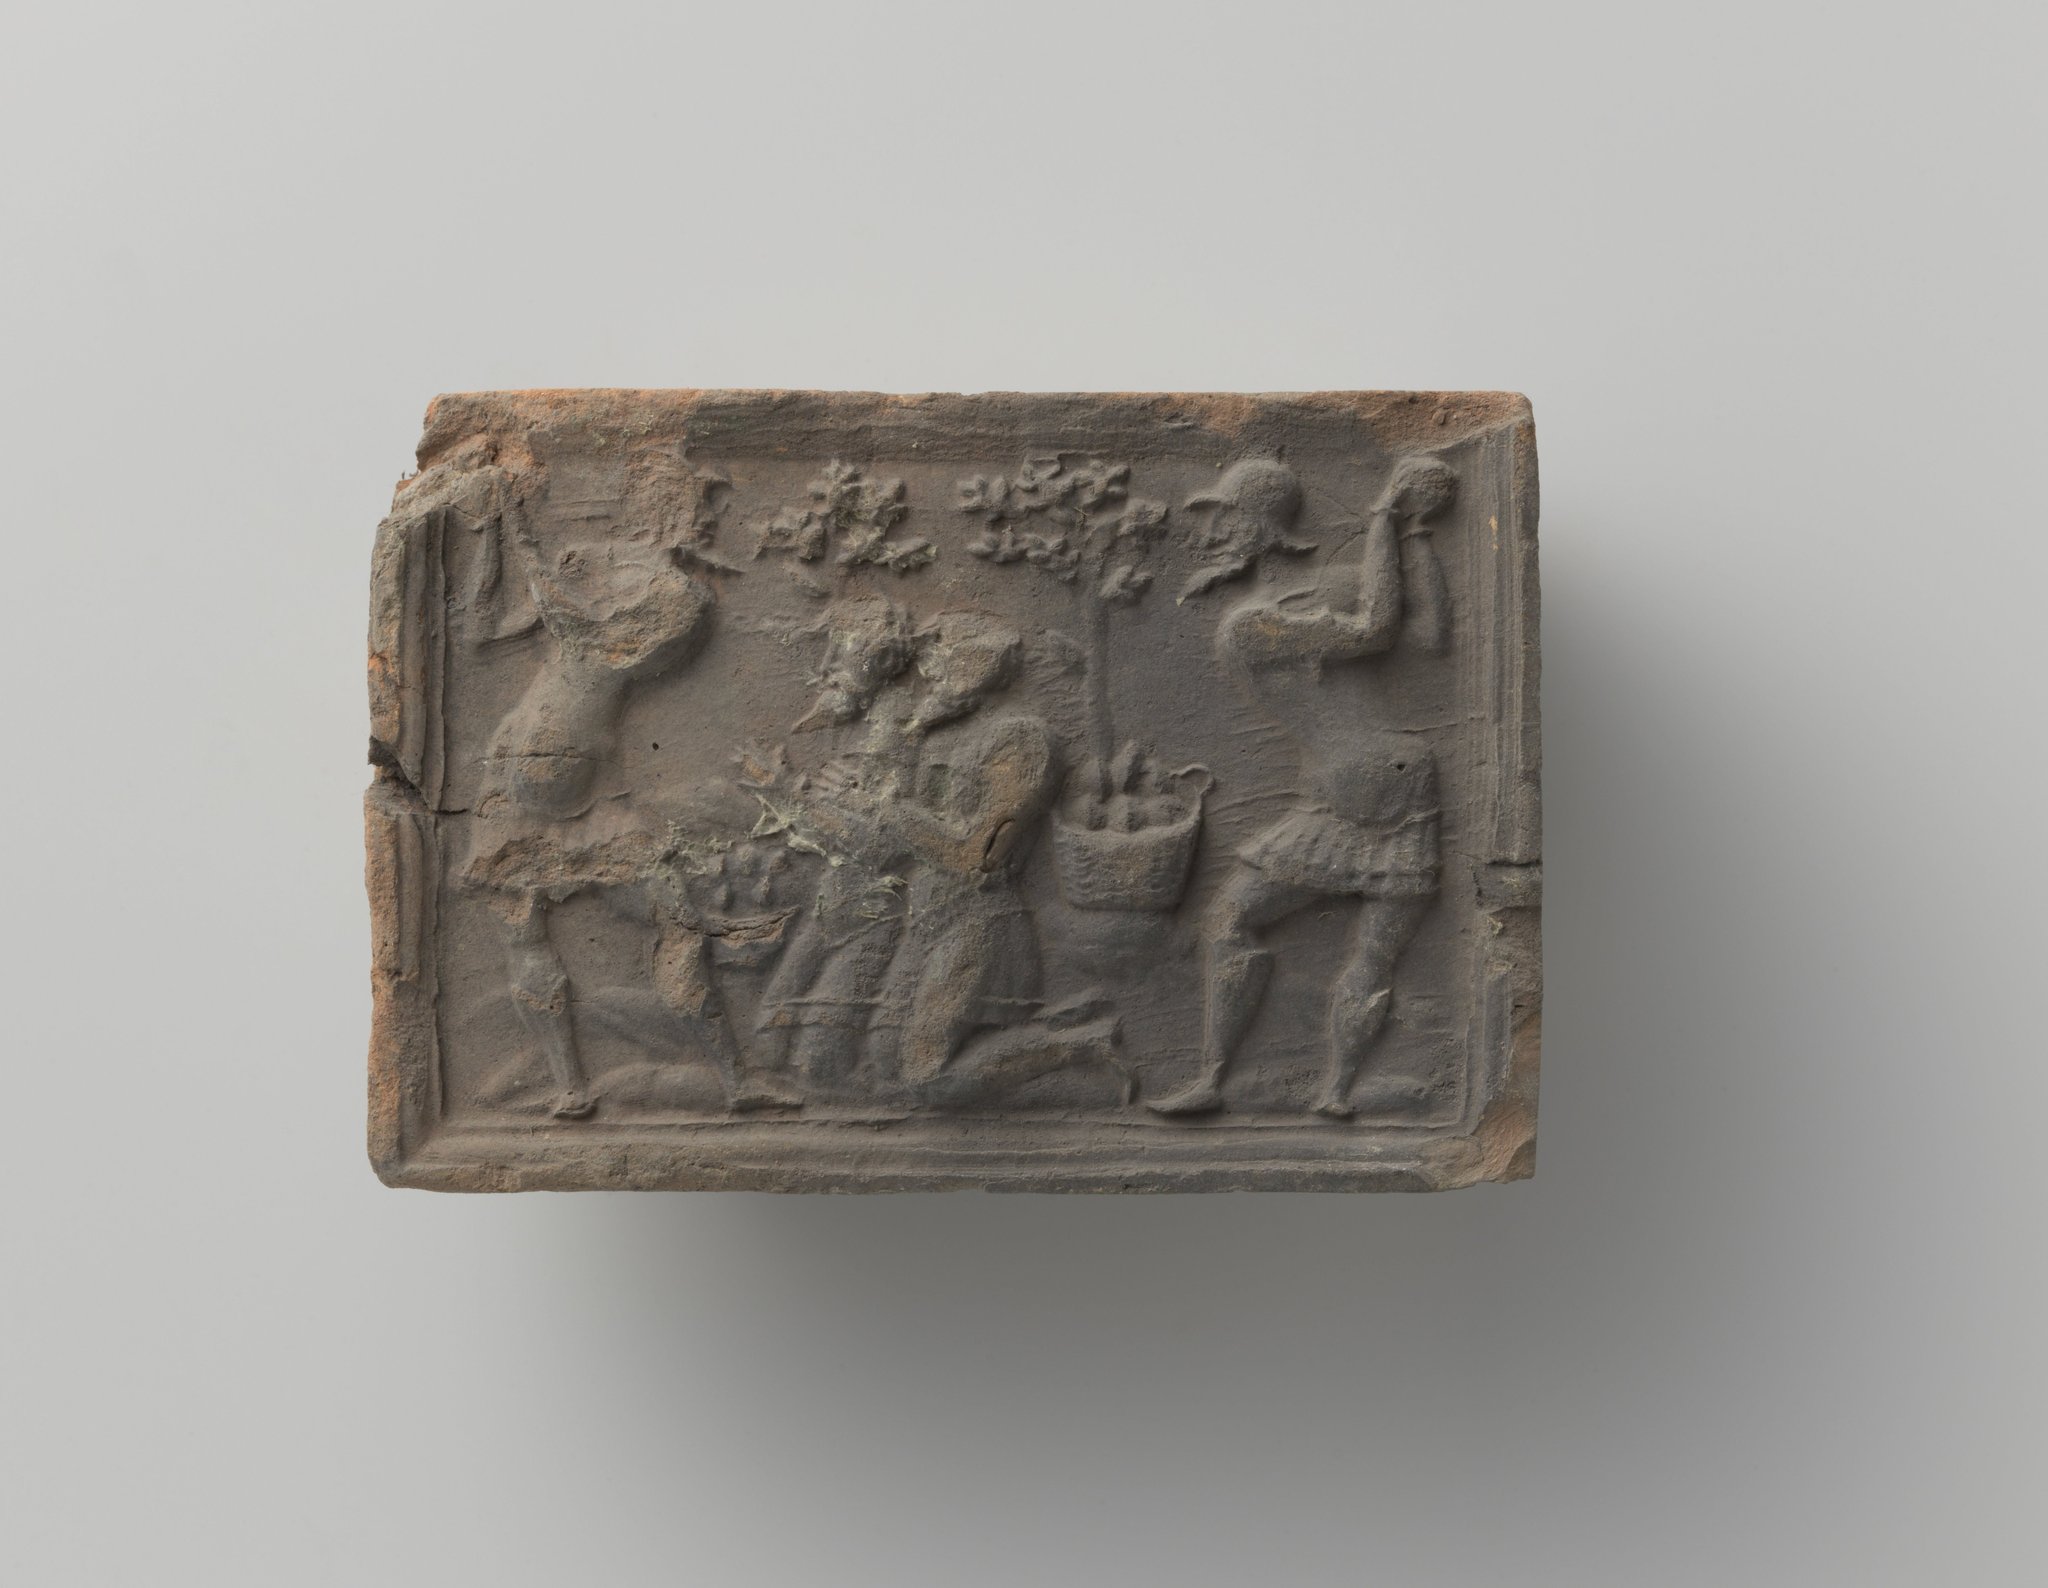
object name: hearthstone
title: Haardsteen, Susanna, de onthoofding van de boeven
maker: Anonymous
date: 1525-1575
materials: earthenware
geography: antwerp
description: haardsteen met een voorstelling van de steniging, door twee soldaten, van de twee ouderlingen uit de geschiedenis van Susanna. Op de achtergrond een mand met stenen en een boom.